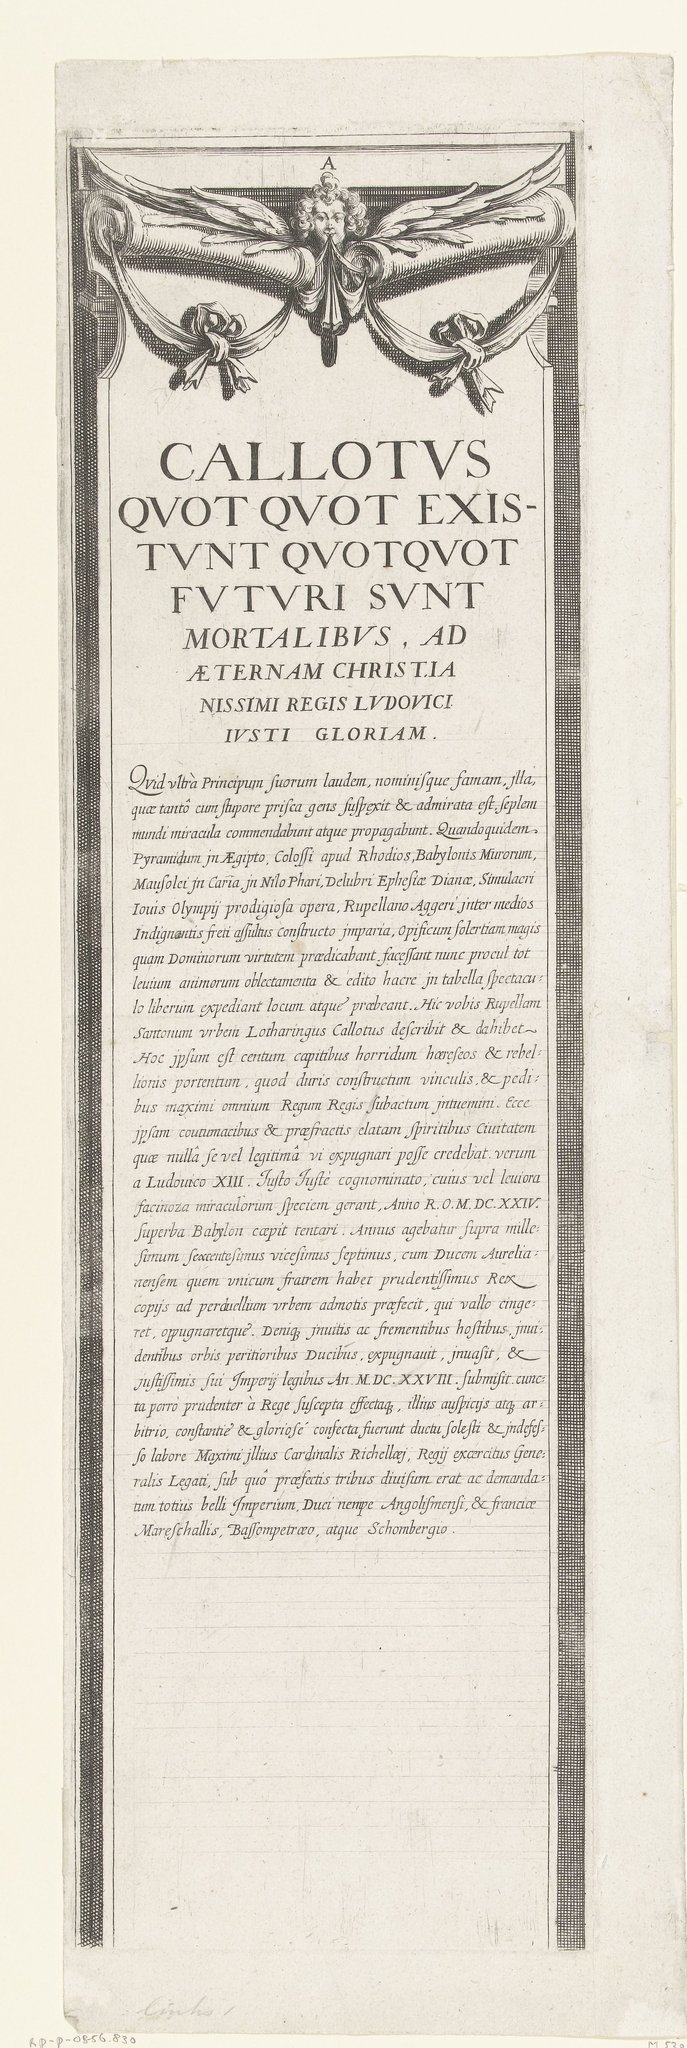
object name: print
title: Callotus quot quot existunt quotquot futuri sunt mortalibus, ad aeternam christianissimi regis Ludovici Iusti gloriam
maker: Anonymous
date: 1628-1631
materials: paper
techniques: engraving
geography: france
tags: la rochelle, beleg van la rochelle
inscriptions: collector's mark: Lugt 240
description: Zestiende deel (tekst, deel rechtsboven) van een prent van het beleg van het hugenotenbolwerk La Rochelle in de jaren 1627 en 1628, dat werd uitgevoerd in opdracht van de Franse koning door het Franse leger onder aanvoering van kardinaal Richelieu. Op dit blad een algemene toelichting op het onderwerp van de prent, in het Latijn.